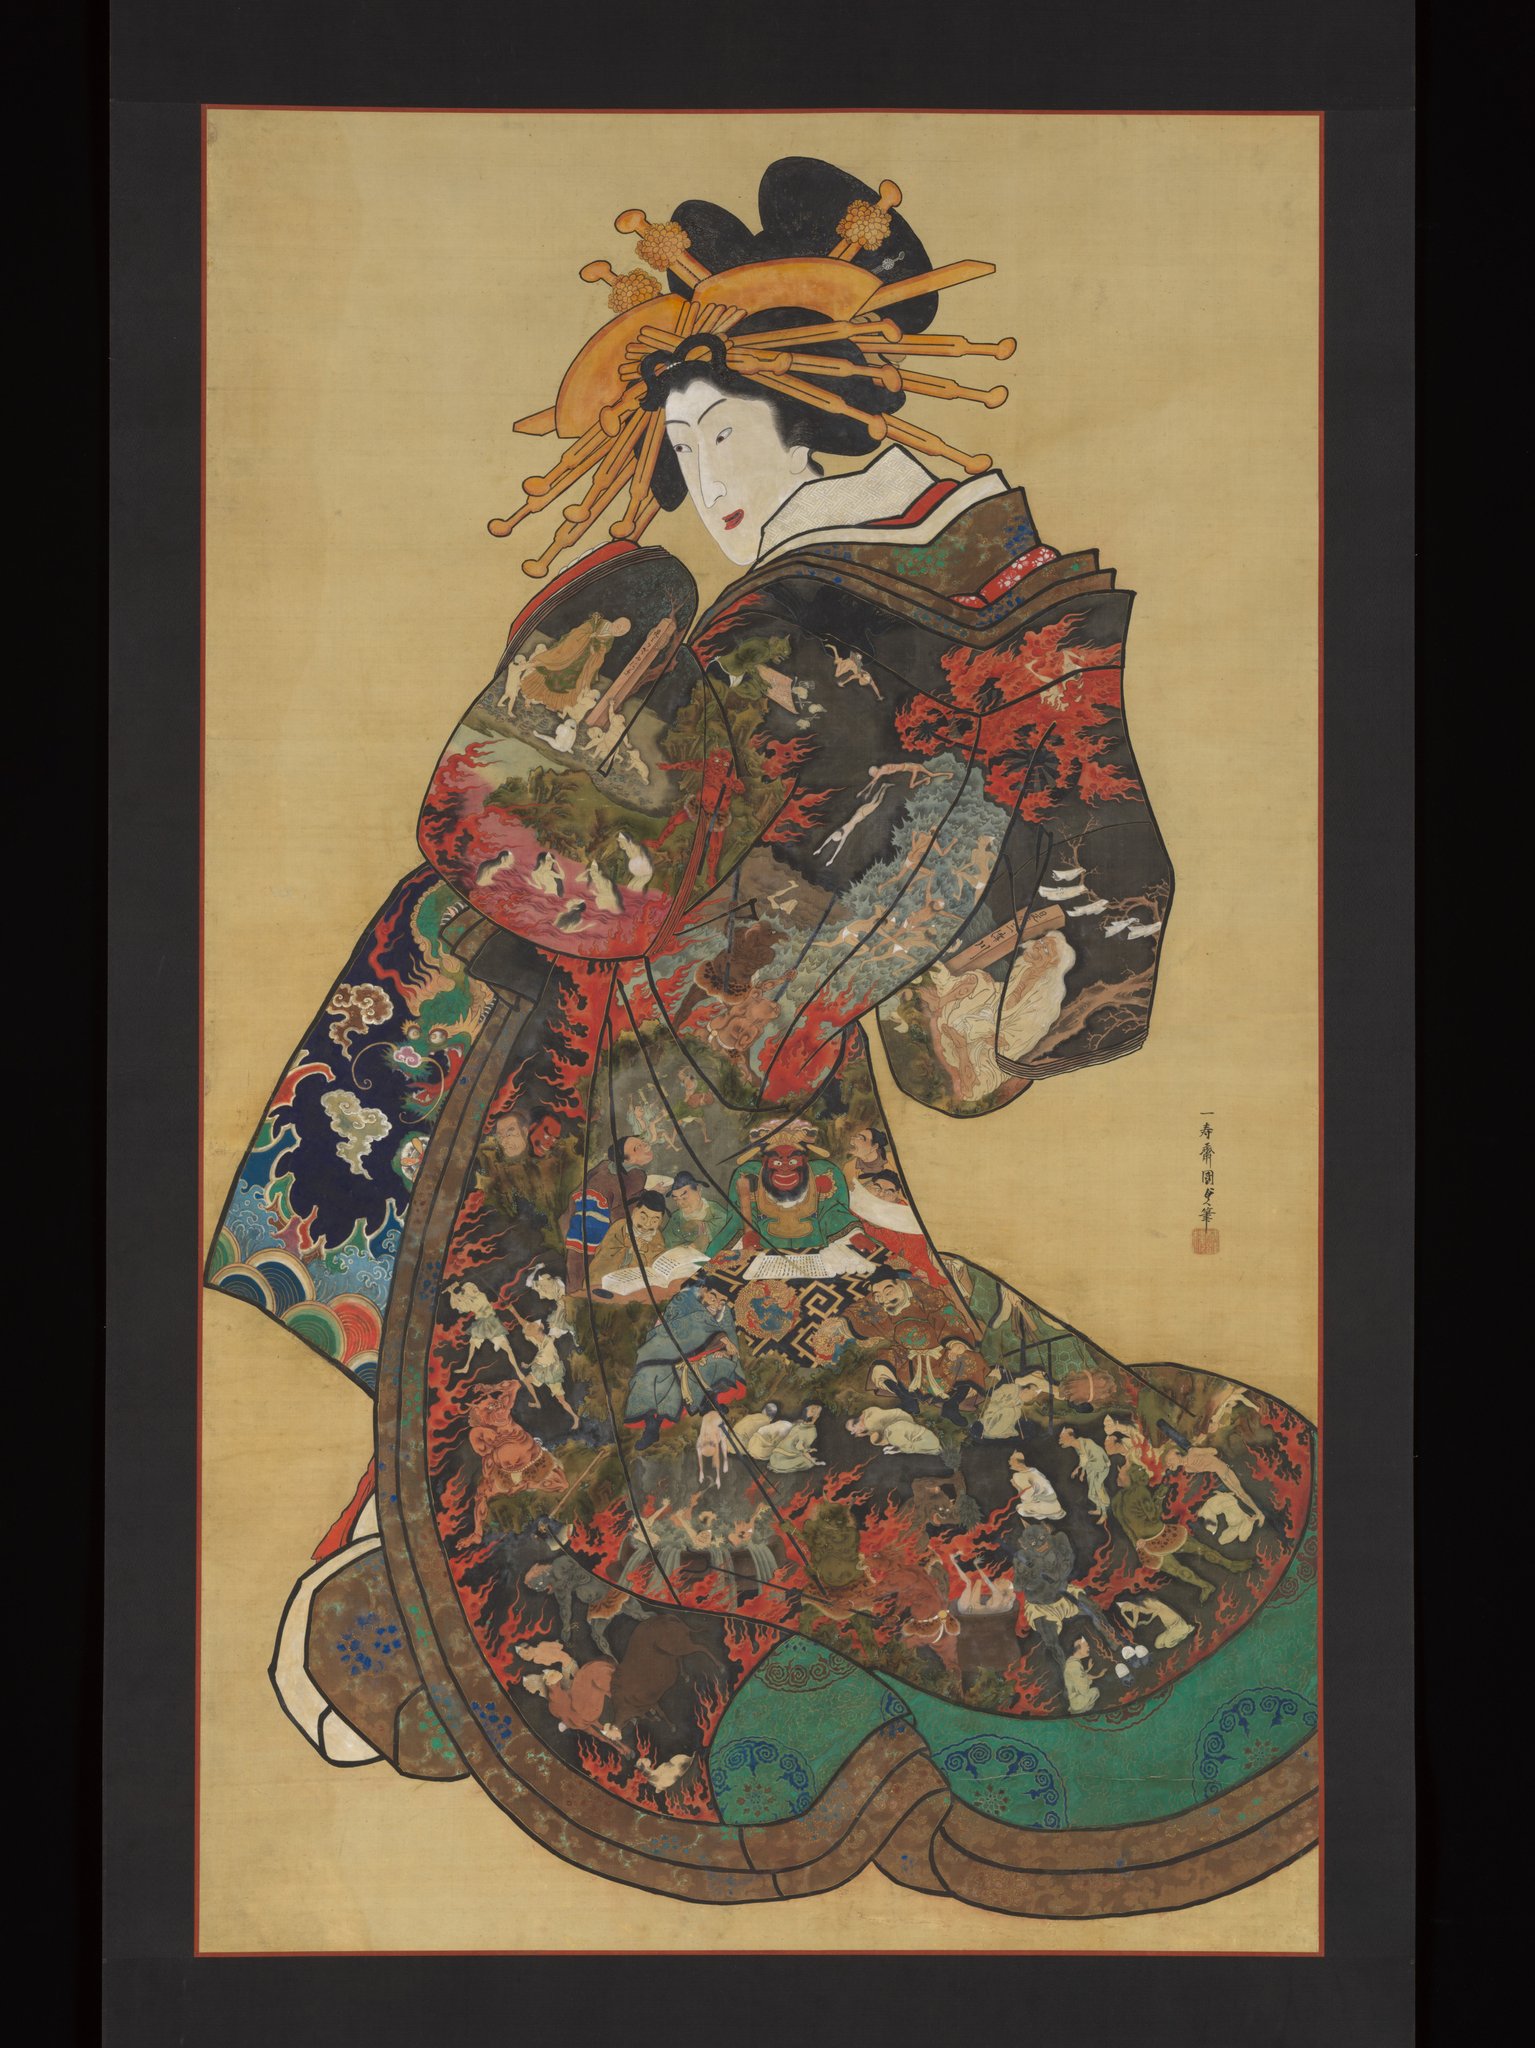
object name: hanging scroll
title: The Hell Courtesan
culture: japanese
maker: utagawa kunisada ii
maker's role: artist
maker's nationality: japanese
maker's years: 1823-1880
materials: ink, silk